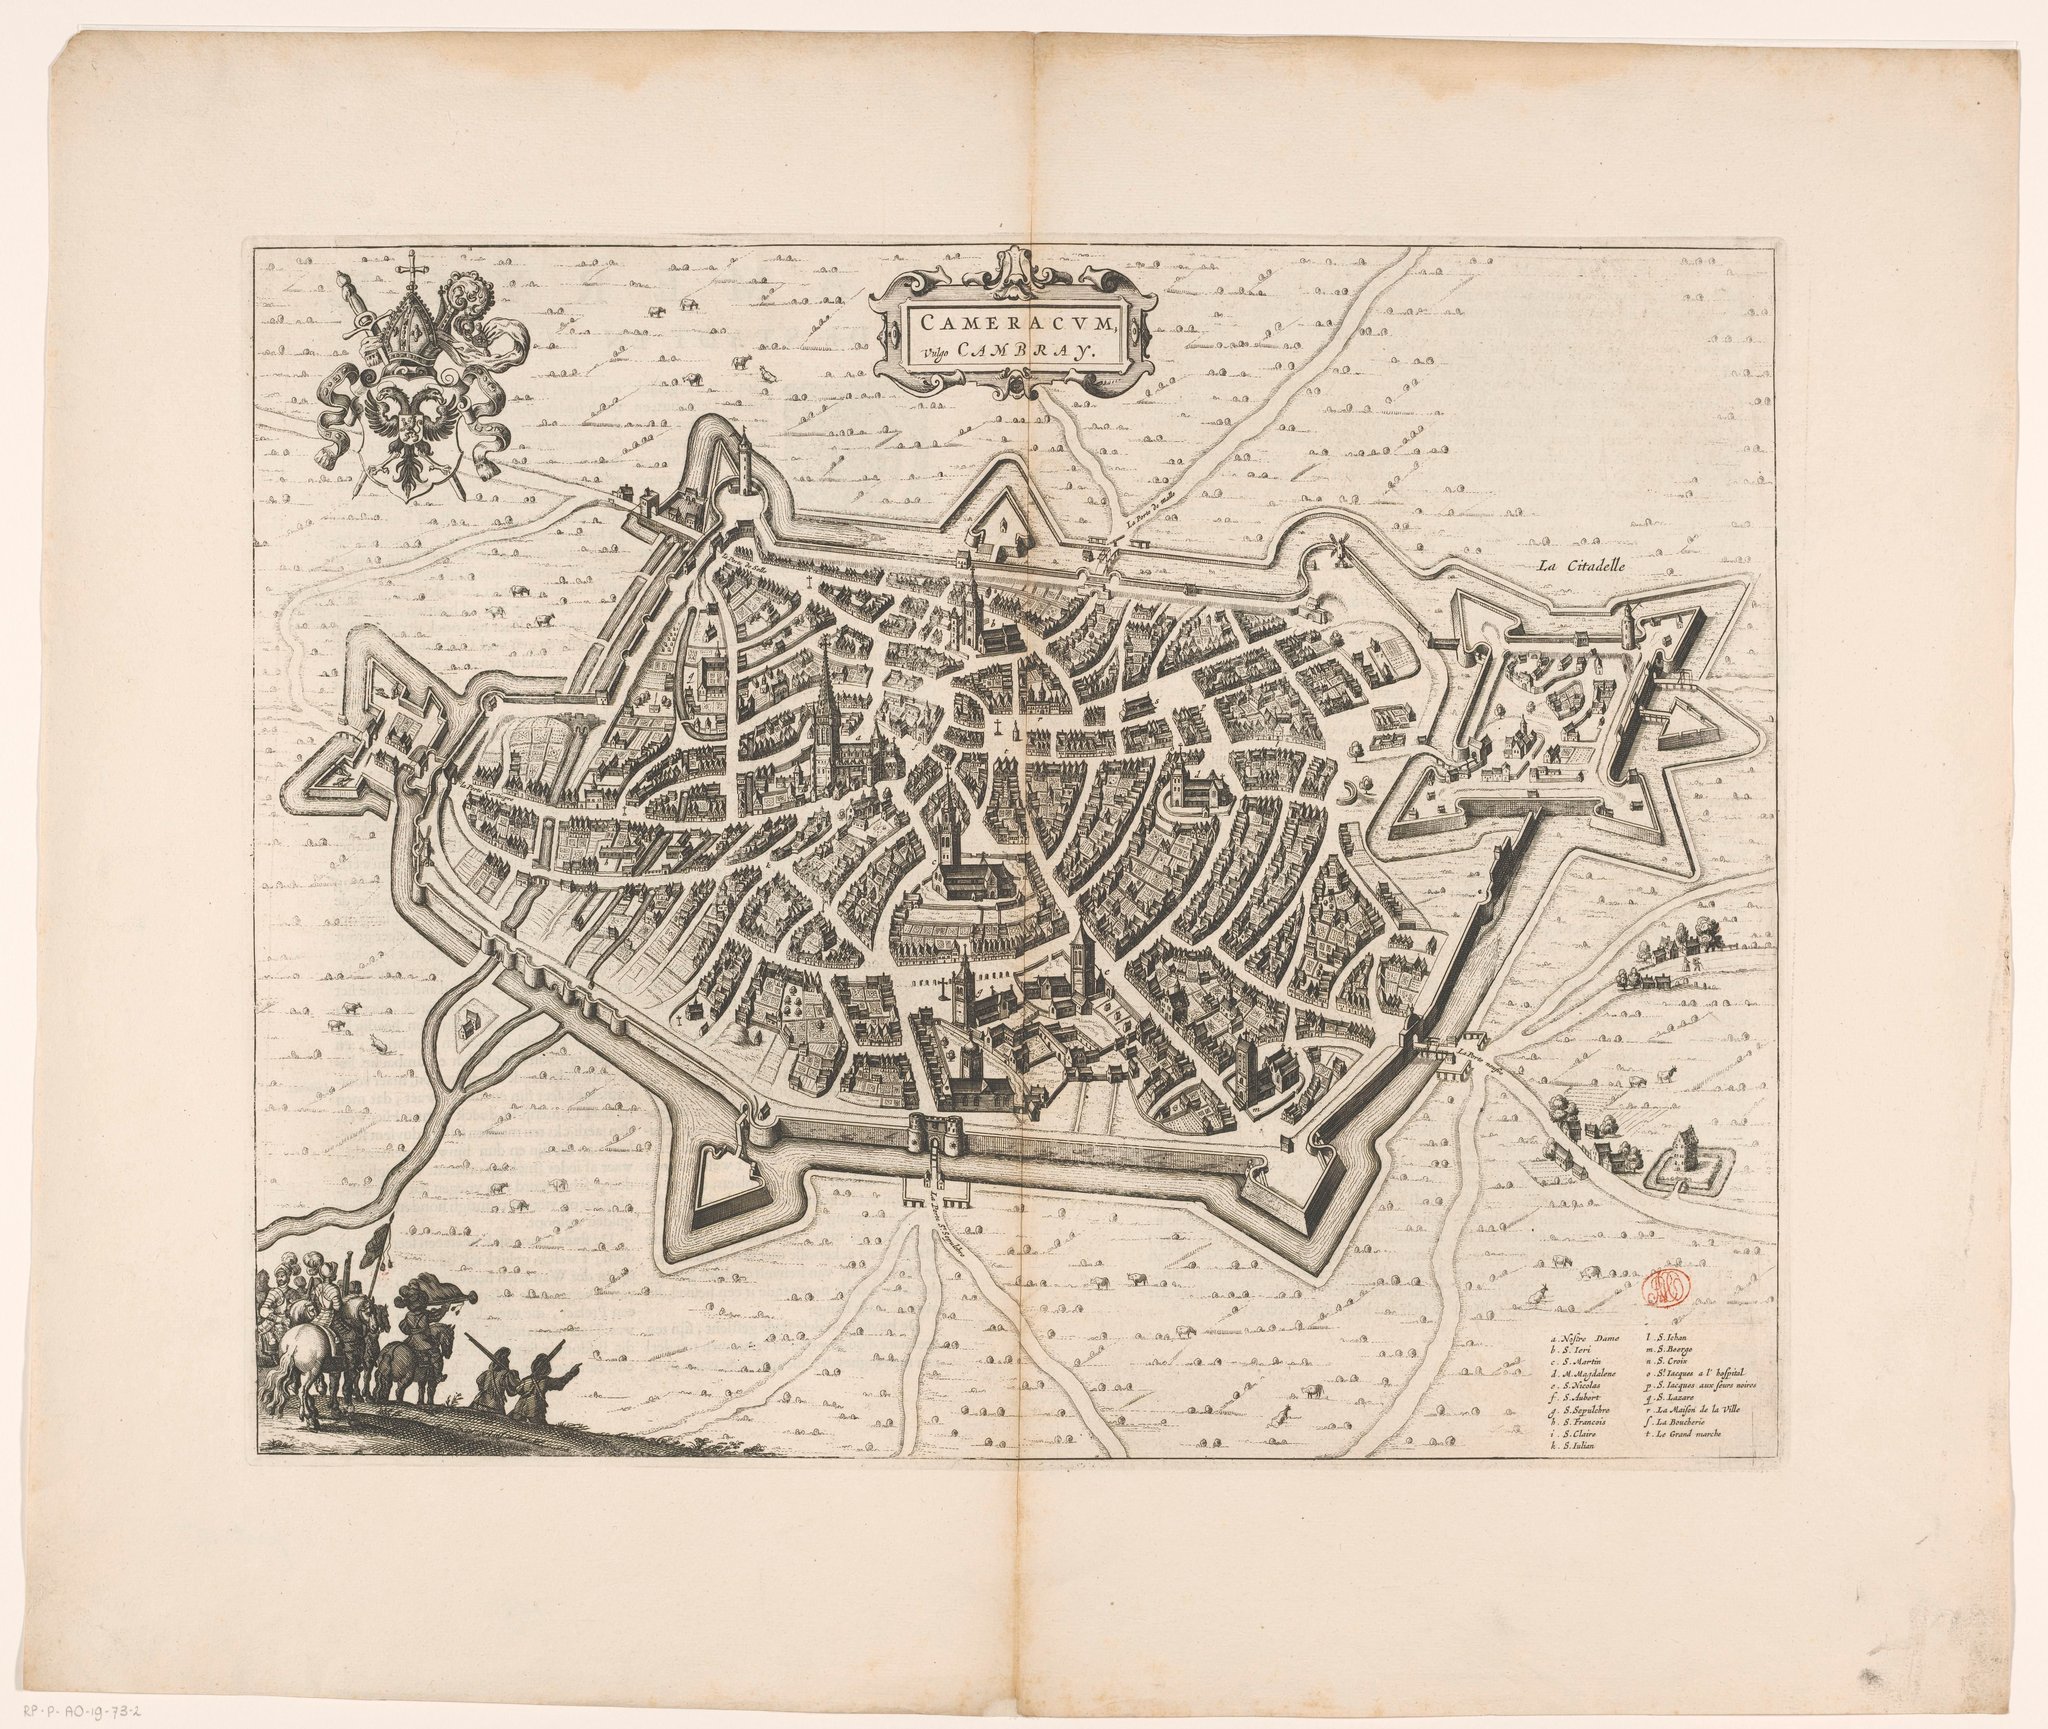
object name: area plan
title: Cameracum, vulgo Cambray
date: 1652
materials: paper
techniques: engraving, etching, letterpress printing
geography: amsterdam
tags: coat of arms (as symbol of the state, etc.) (+ city; municipal), fortified city, maps of cities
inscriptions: collector's mark: Lugt 195, collector's mark: Lugt 2228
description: Plattegrond van Kamerijk met gebouwen in vogelvluchtperspectief. Boven, in het midden, de titelcartouche. Linksboven het wapen van het Kamerijk. Rechtsonder een kader met legenda a-t. Met Nederlandse tekst op verso.